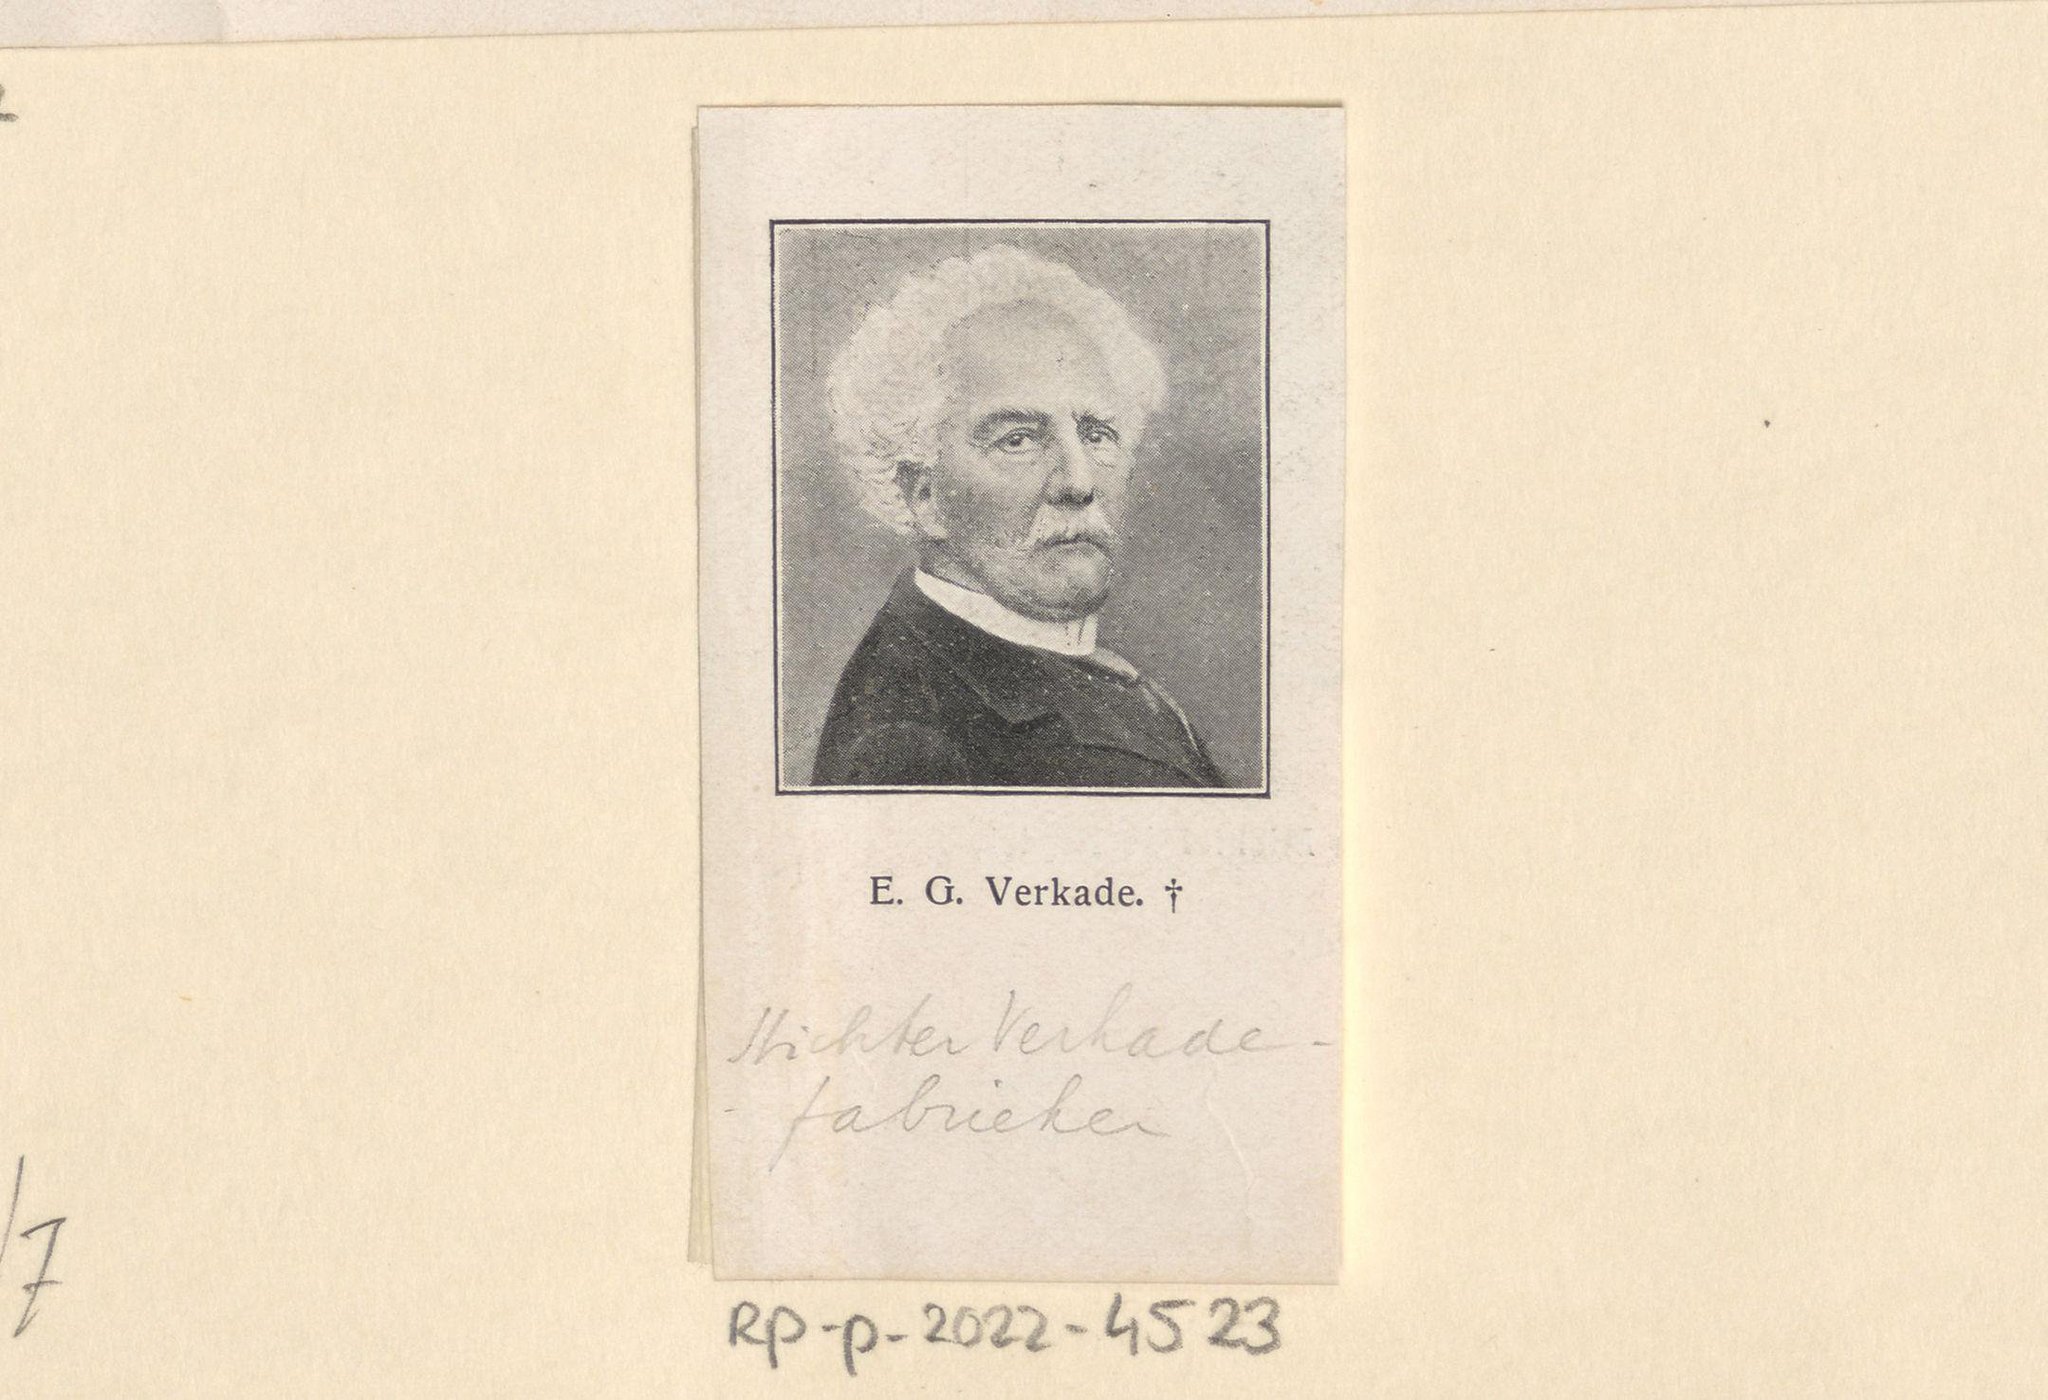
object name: photomechanical print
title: Portret van Ericus Gerhardus Verkade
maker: Anonymous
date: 1907-1920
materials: paper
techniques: autotype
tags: director, boss (in modern industry), historical persons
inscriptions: collector's mark: ‘JVB’